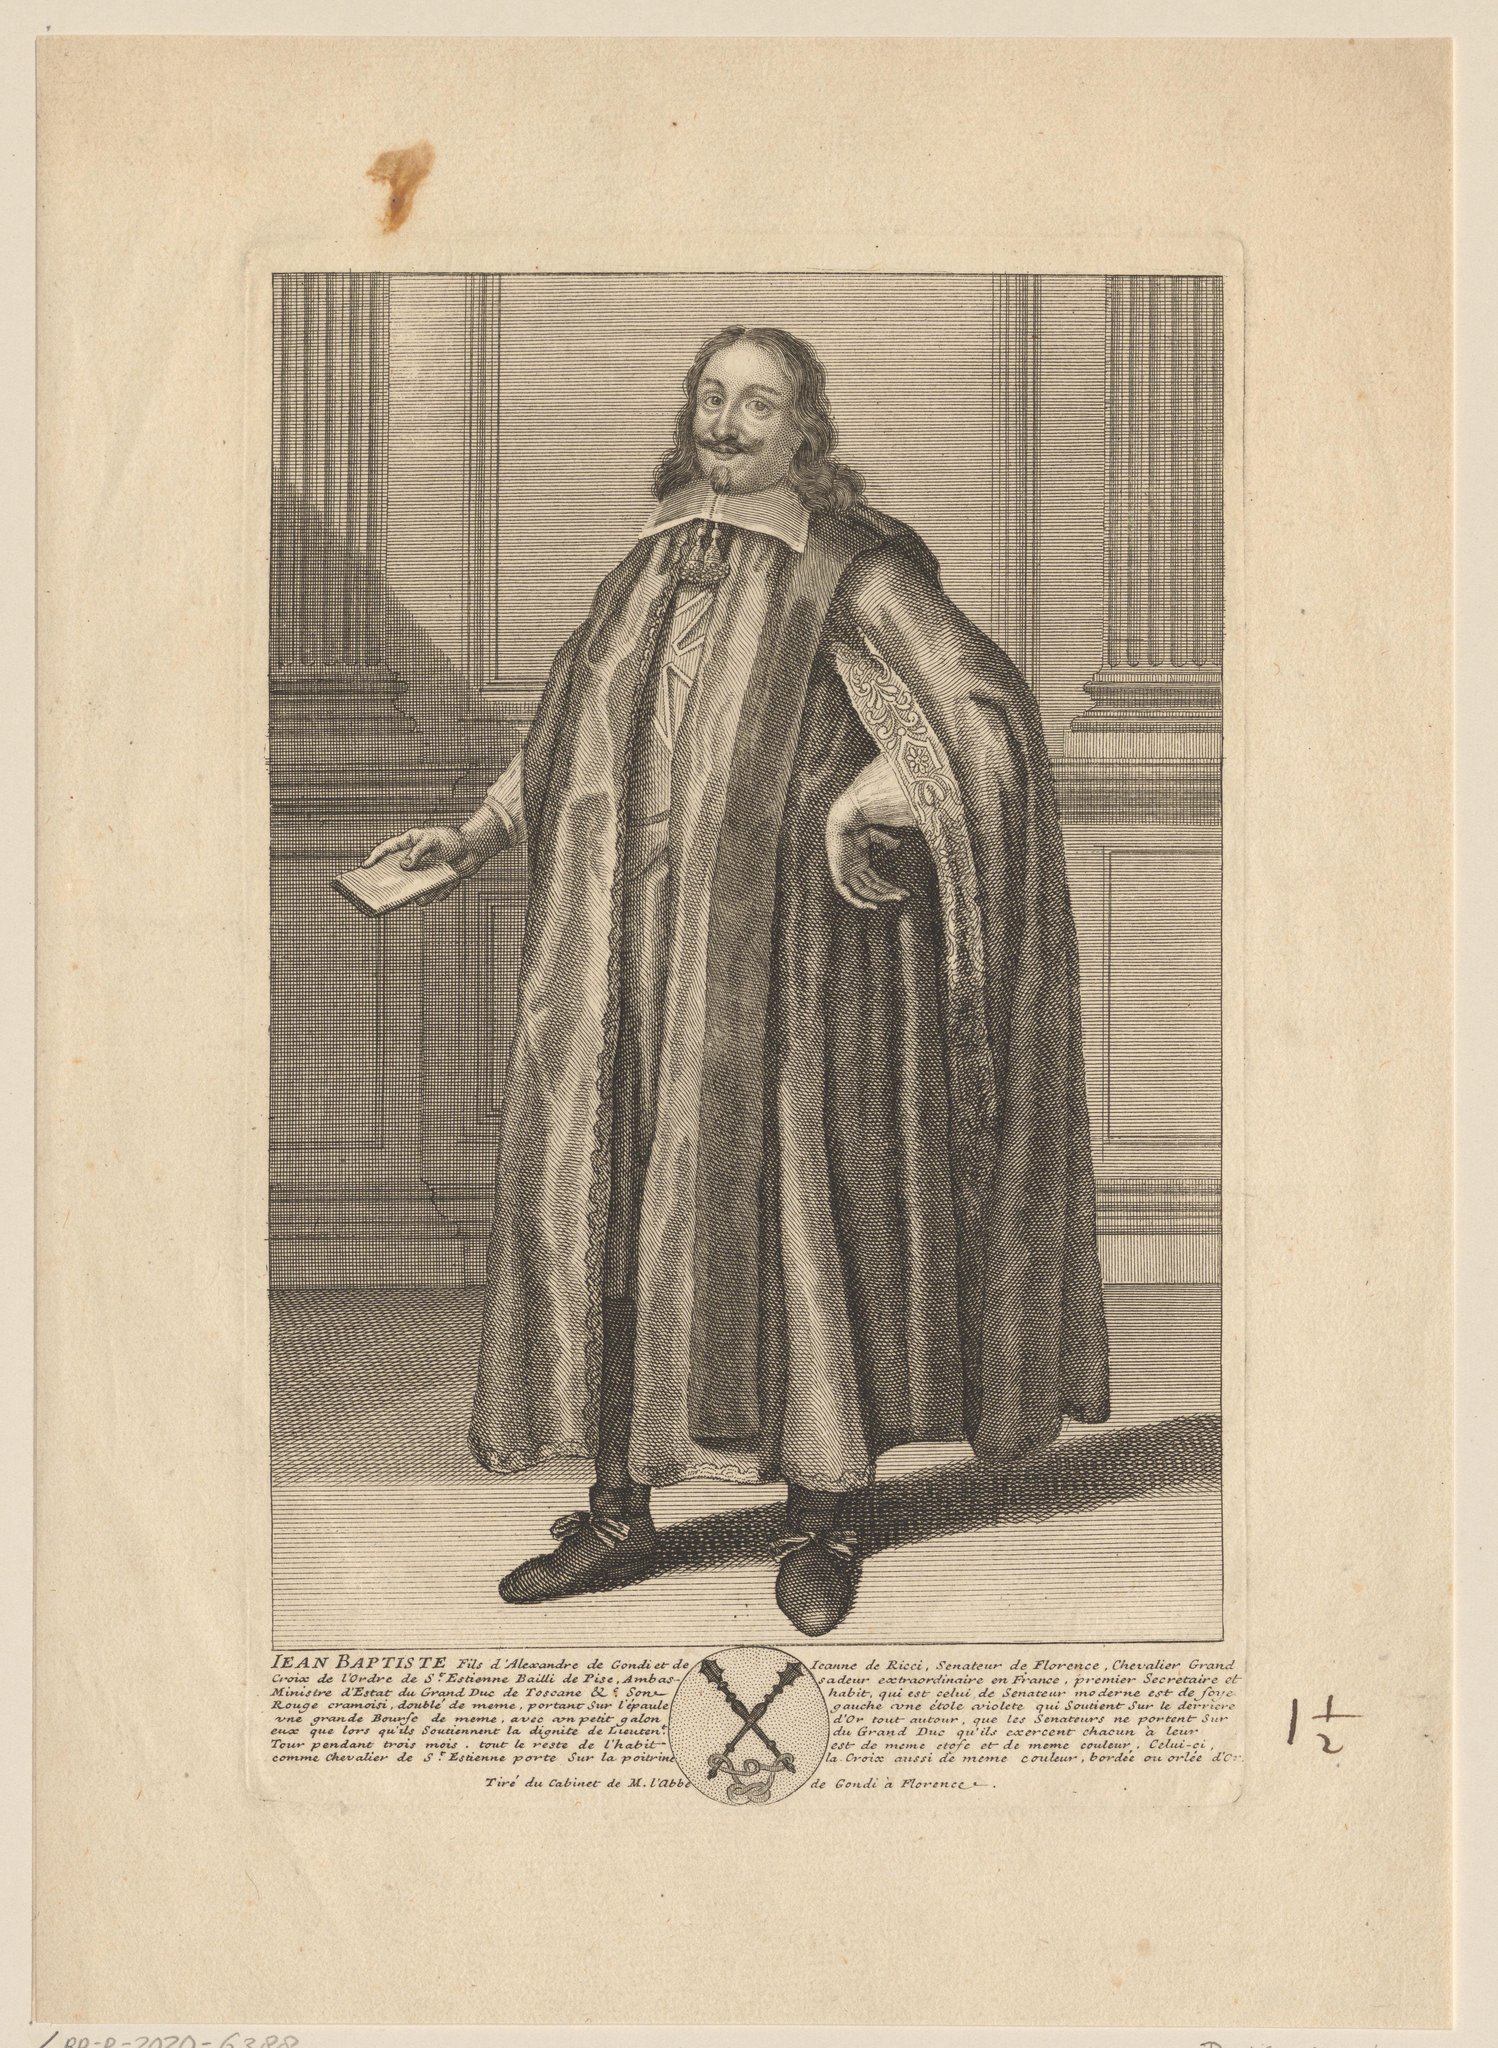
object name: print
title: Portret van Jean Baptiste de Gondi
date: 1705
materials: paper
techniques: engraving, etching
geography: paris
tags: historical persons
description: Prent uit: Corbinelli, Jean de. Histoire genealogique de la maison de Gondi. Parijs: Jean-Baptiste Coignard, 1705.